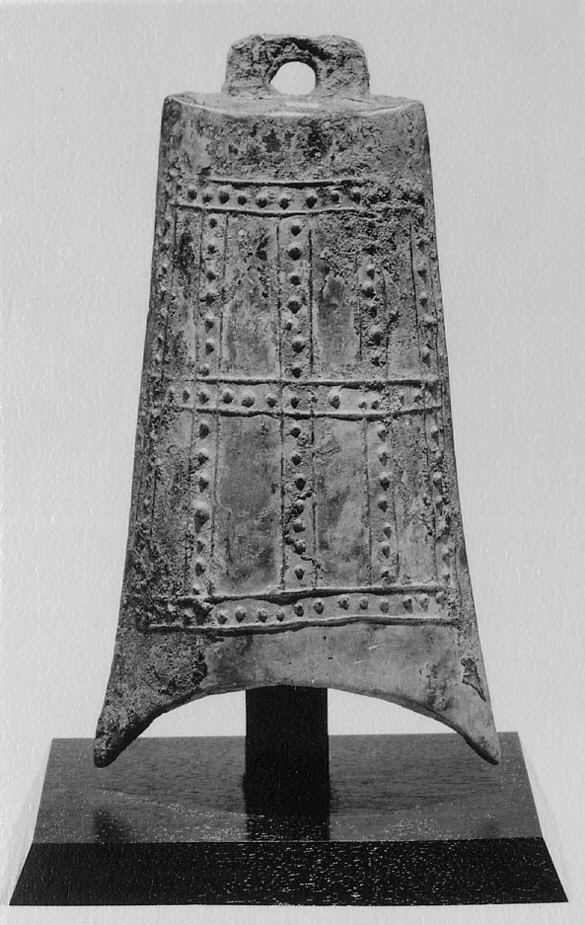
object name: horse bell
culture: japanese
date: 501-600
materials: bronze